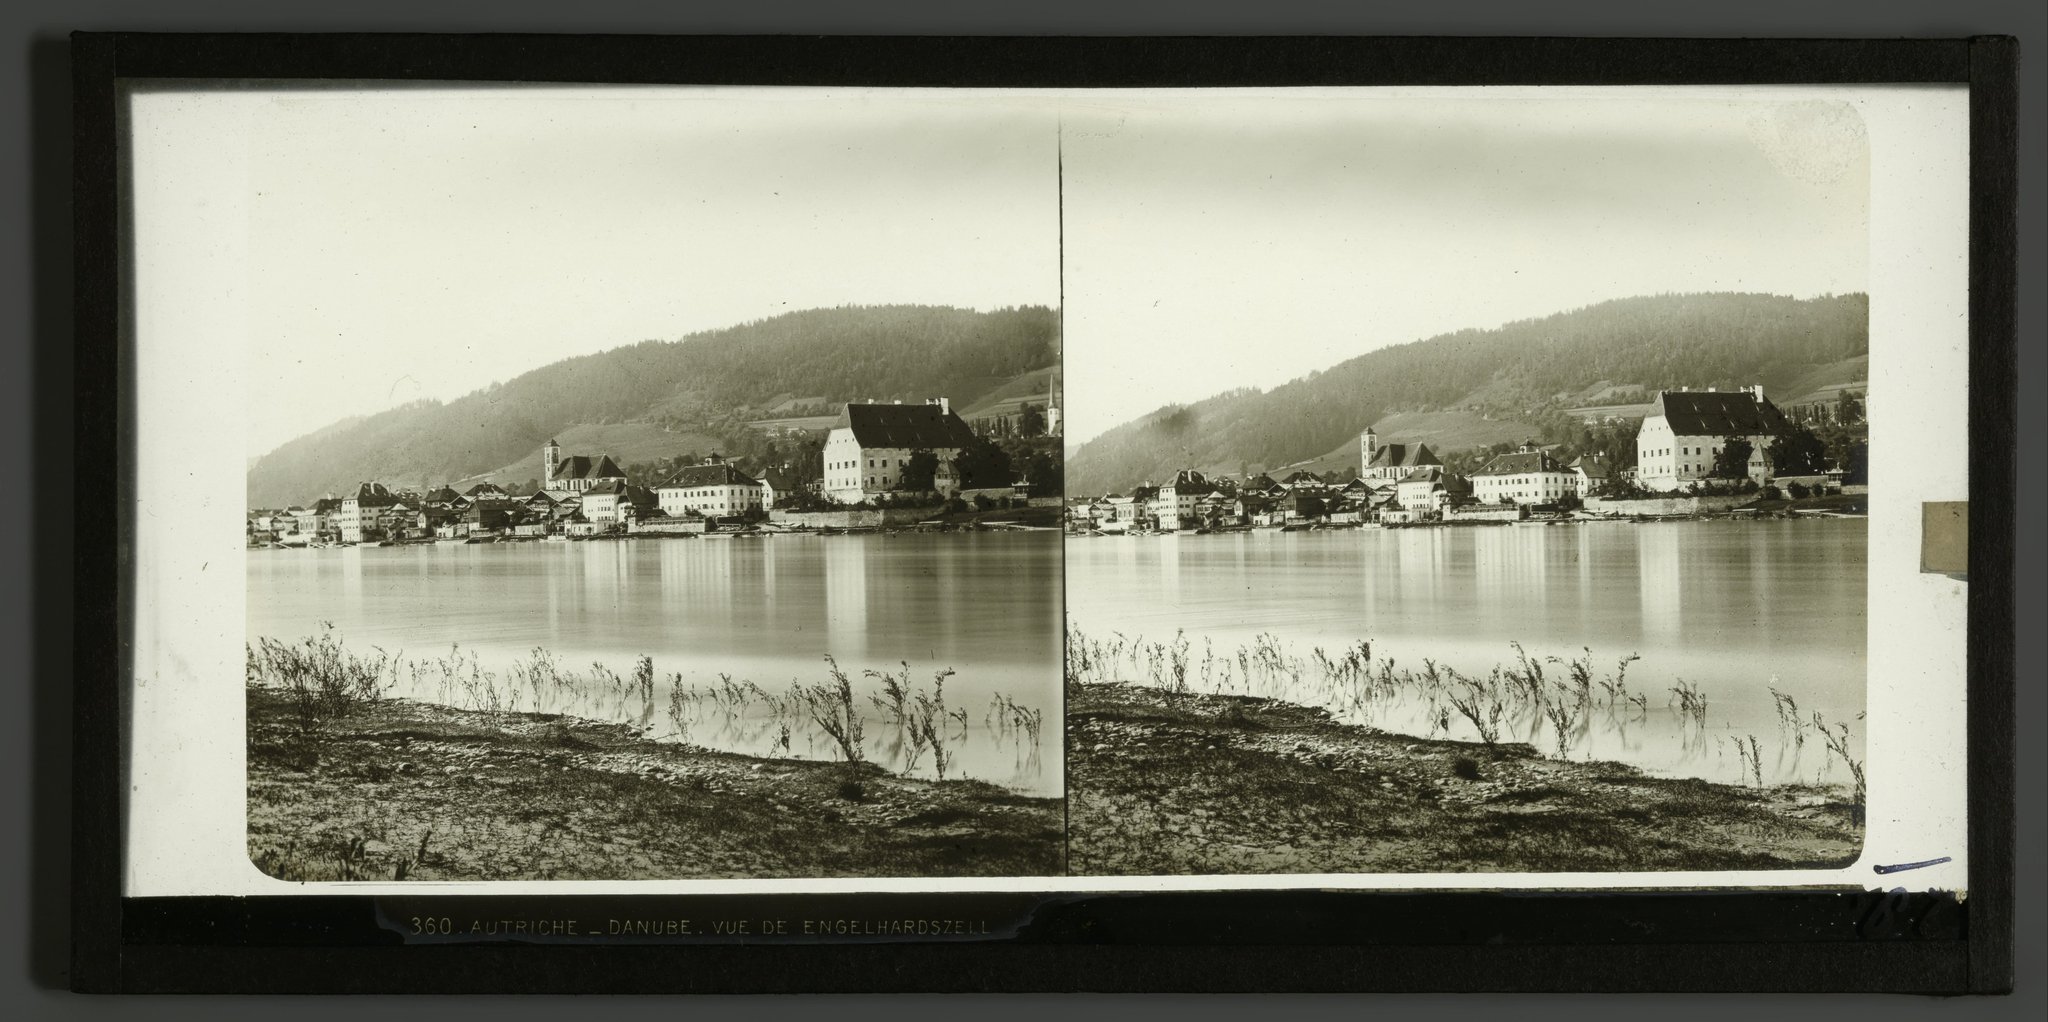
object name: stereoscopic photograph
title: Autriche Danube, vue de Engelhartszell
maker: Anonymous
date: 1856-1890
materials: glass, paper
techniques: slide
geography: engelhartszell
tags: river, prospect of city, town panorama, silhouette of city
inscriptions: number: ‘28.’, number: ‘360’